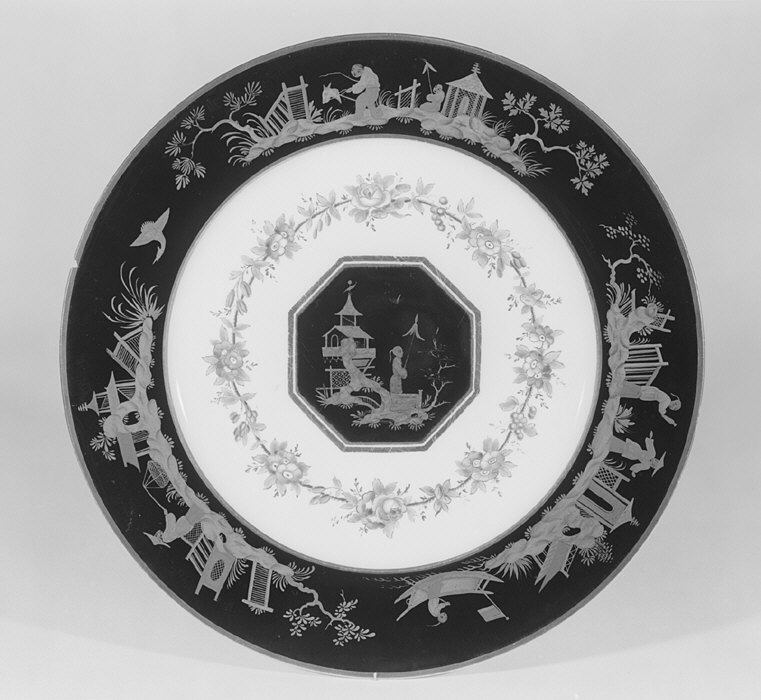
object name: plate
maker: sèvres manufactory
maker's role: manufactory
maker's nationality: french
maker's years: 1740-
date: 1791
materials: hard paste porcelain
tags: houses,men,flowers,trees